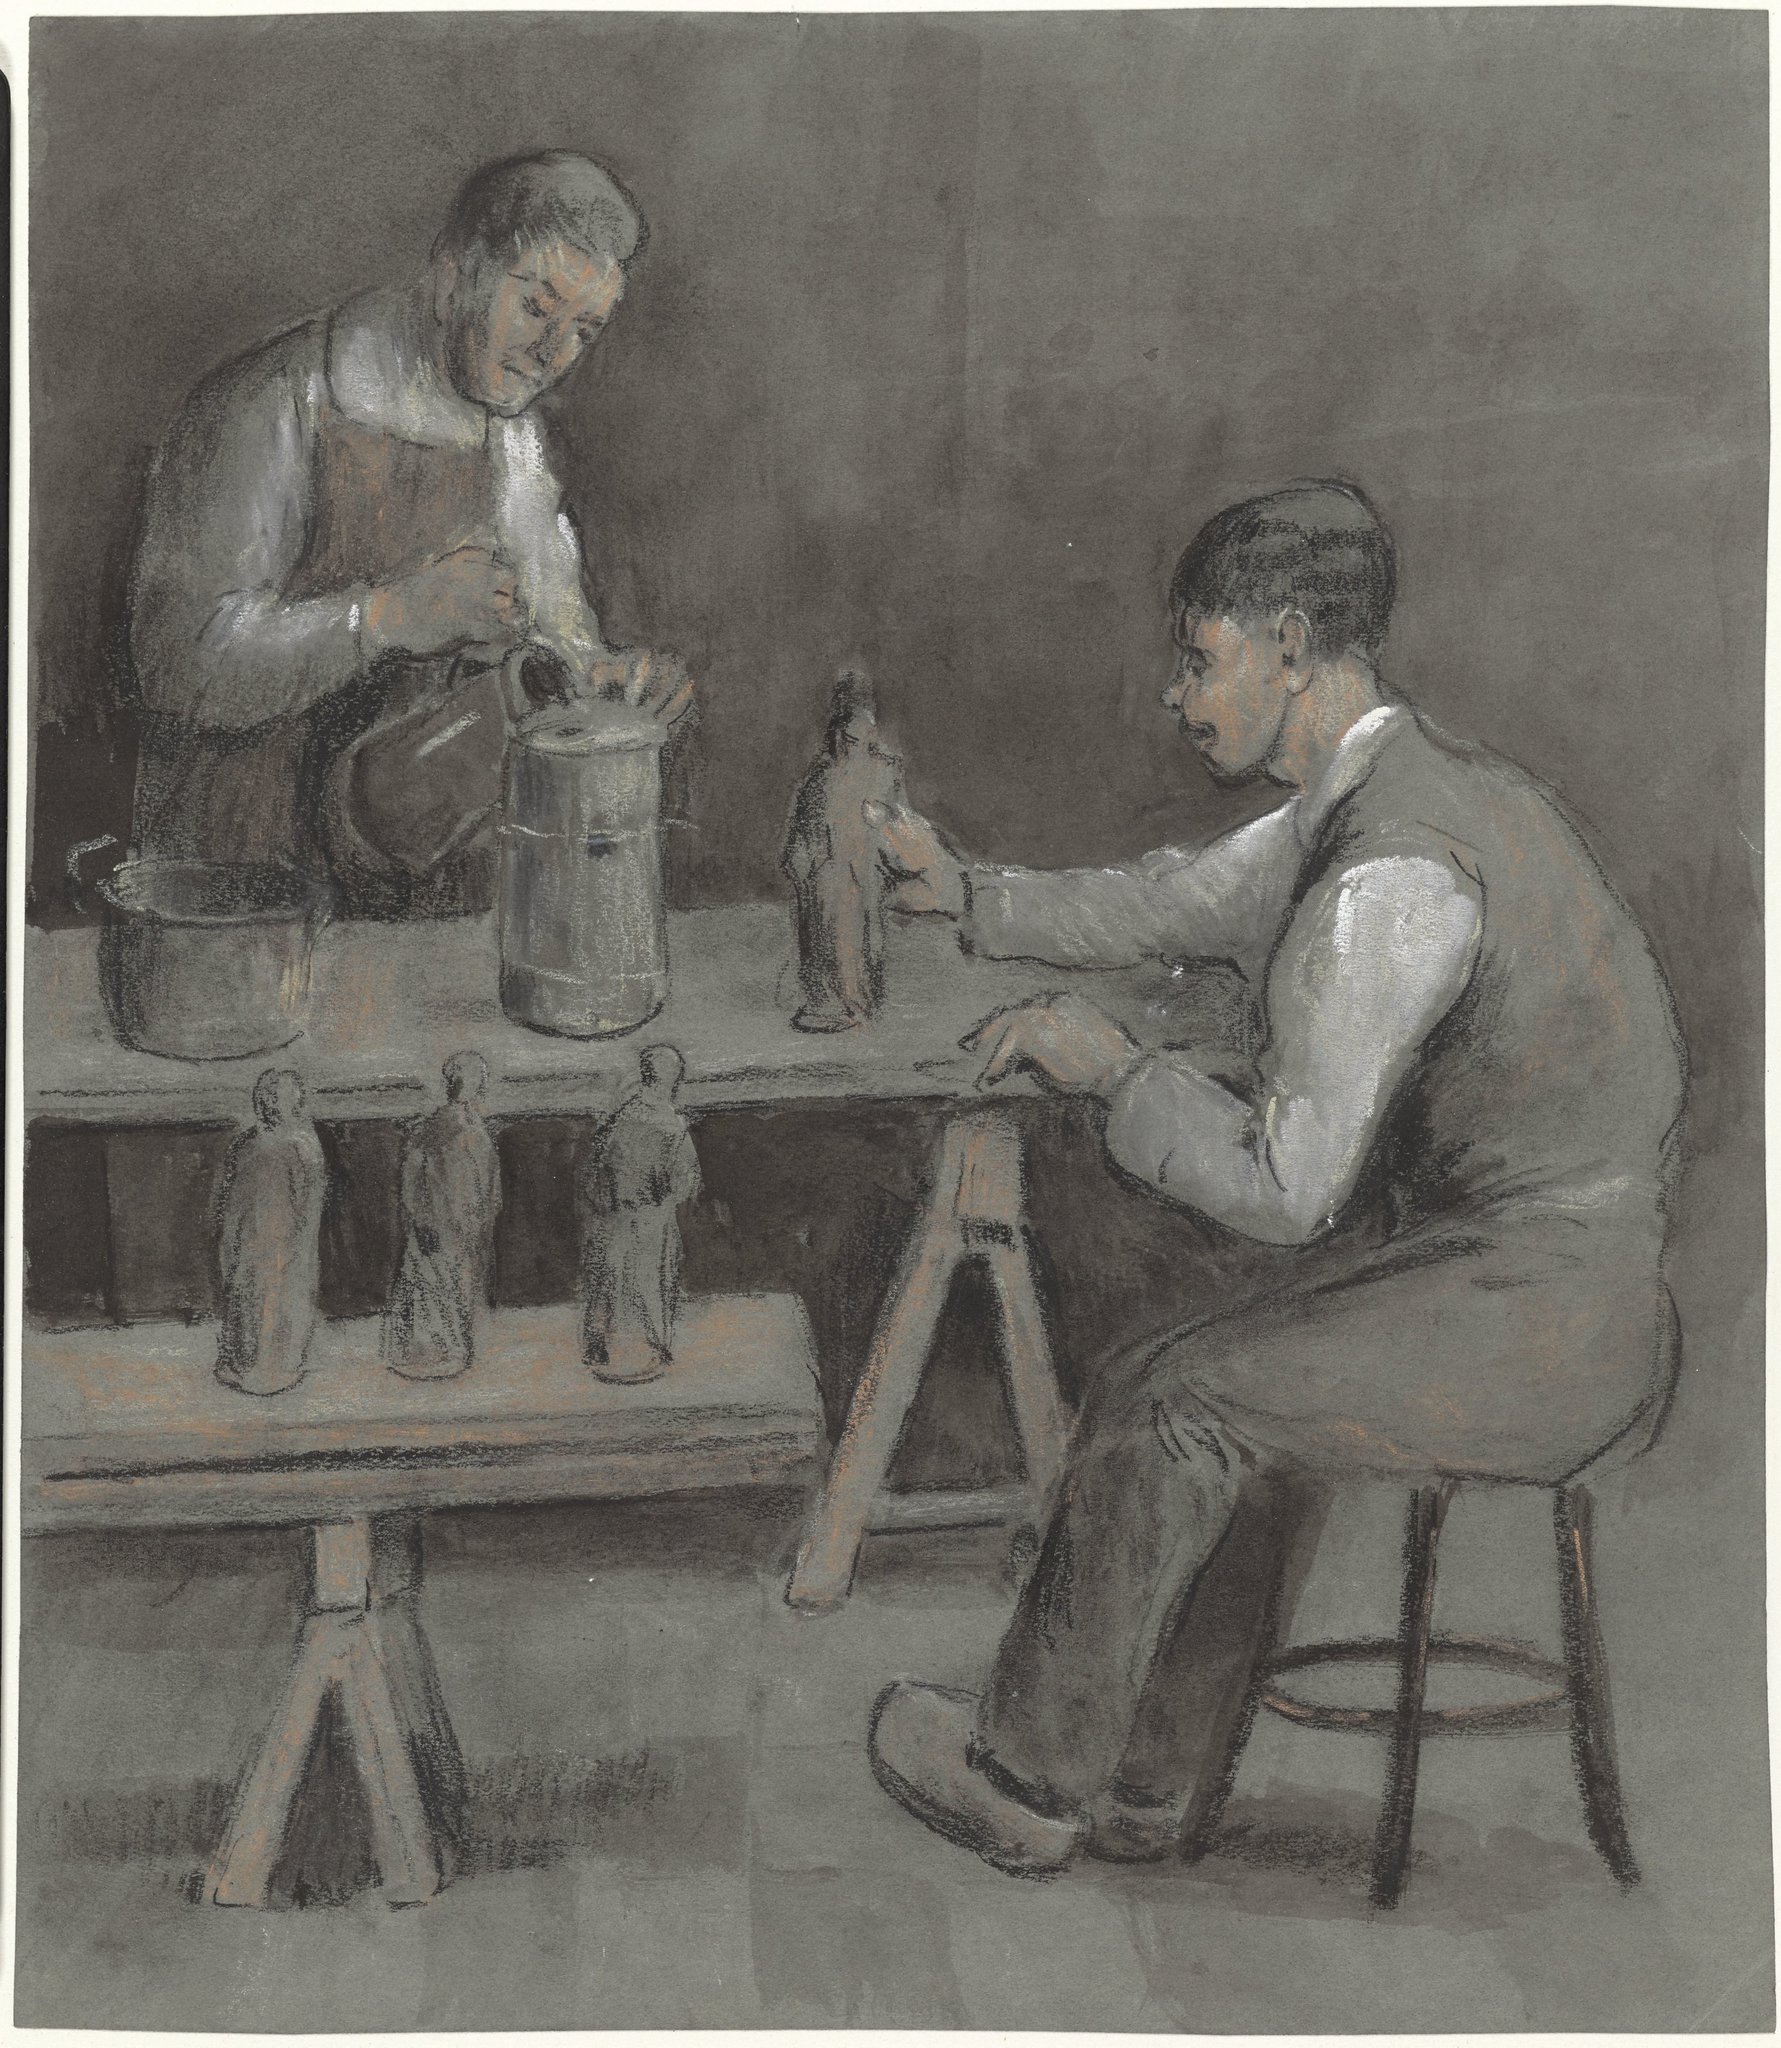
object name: drawing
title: Twee arbeiders bij het maken van beeldjes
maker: herman heijenbrock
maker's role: draughtsman, painter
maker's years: 1871-1948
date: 1881-1948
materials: chalk, paper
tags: (hollow) casting, potter, ceramist